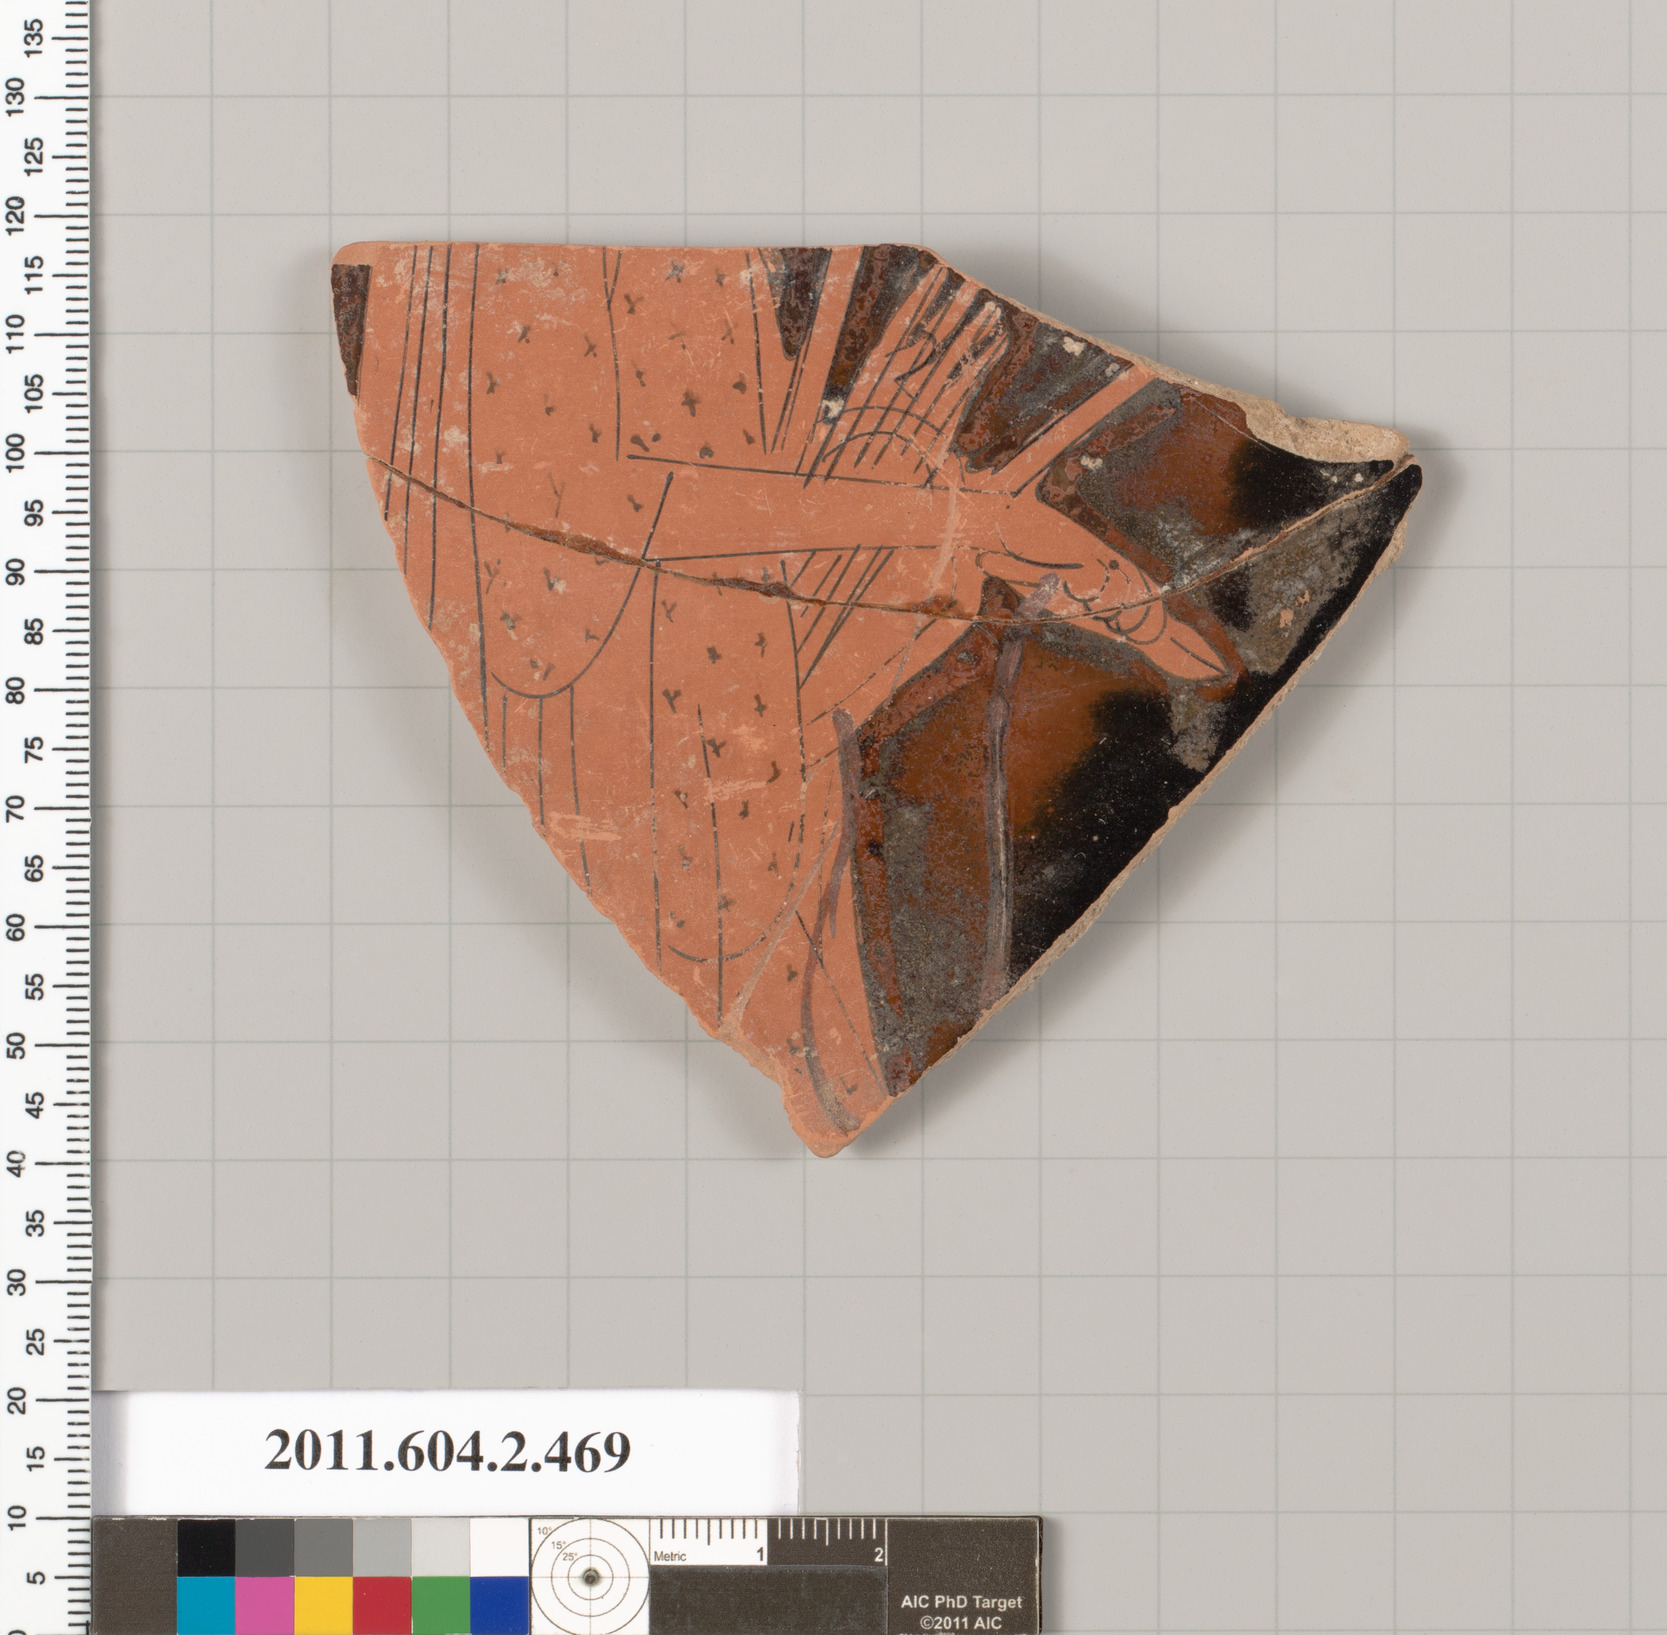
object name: column krater fragment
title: Terracotta fragment of a column-krater (bowl for mixing wine and water)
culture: greek, attic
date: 460-440 BCE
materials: terracotta